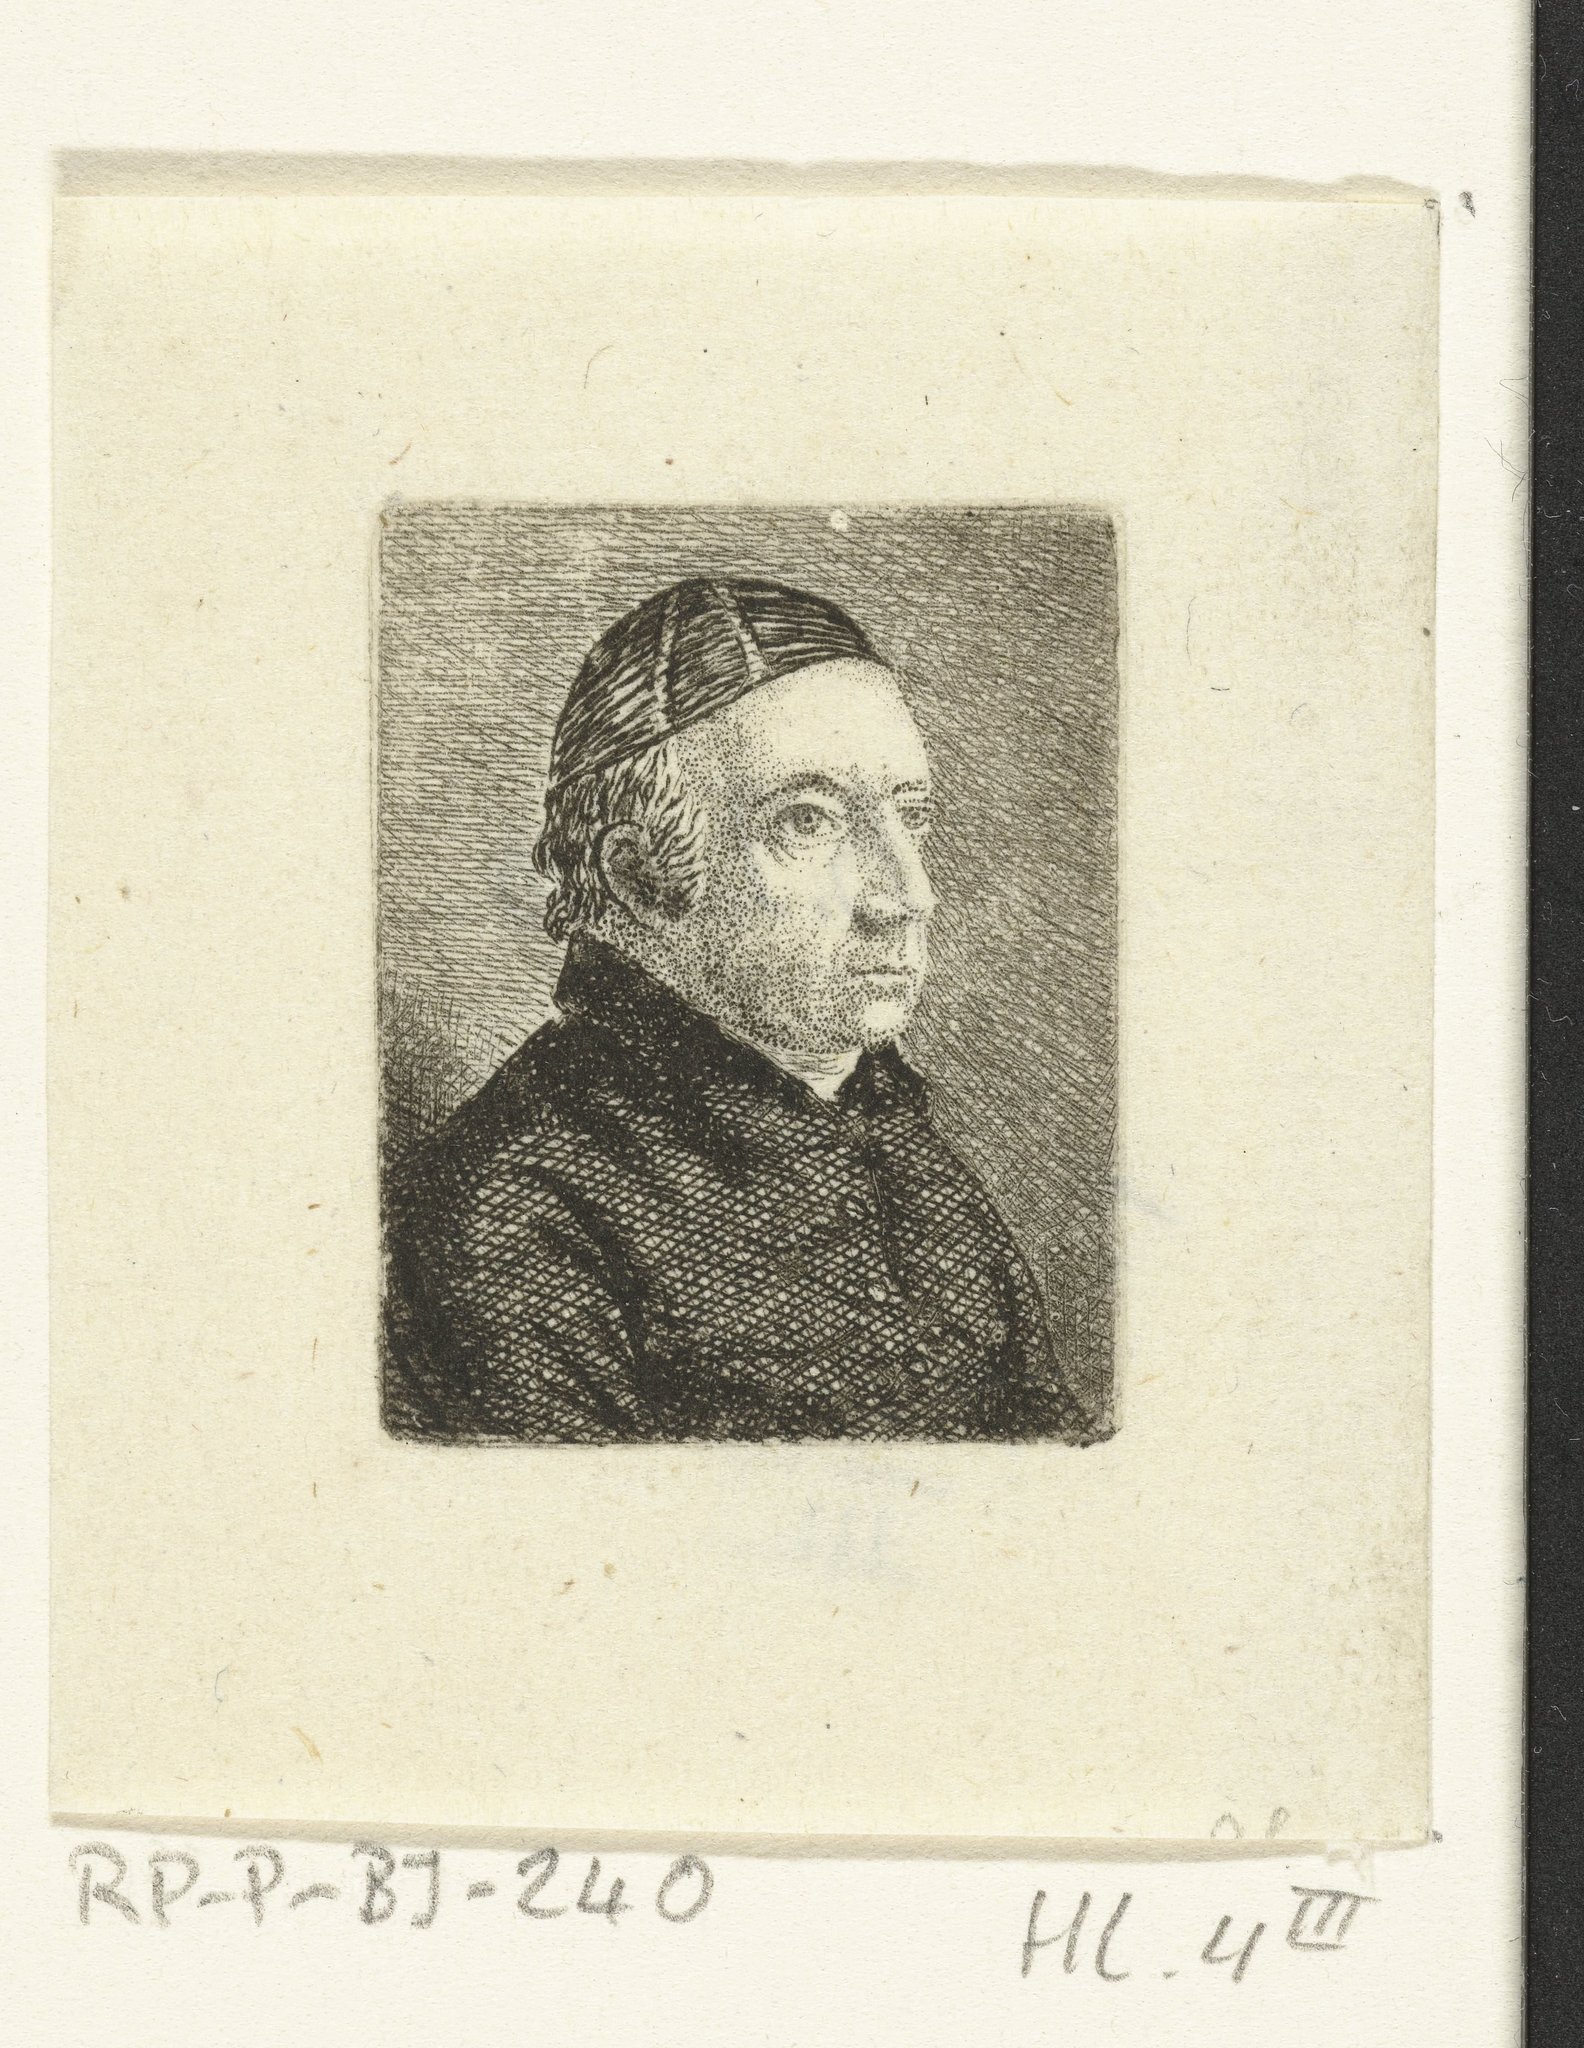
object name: print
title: Portret van de heer Hagedorn koopman uit Bremen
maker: ernst willem jan bagelaar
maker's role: draughtsman, print maker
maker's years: 1775-1837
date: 1798-1837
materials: paper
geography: netherlands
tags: koopman, hermann hagedorn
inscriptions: collector's mark: Lugt 2228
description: Portretbuste van een oudere man met keppeltje.